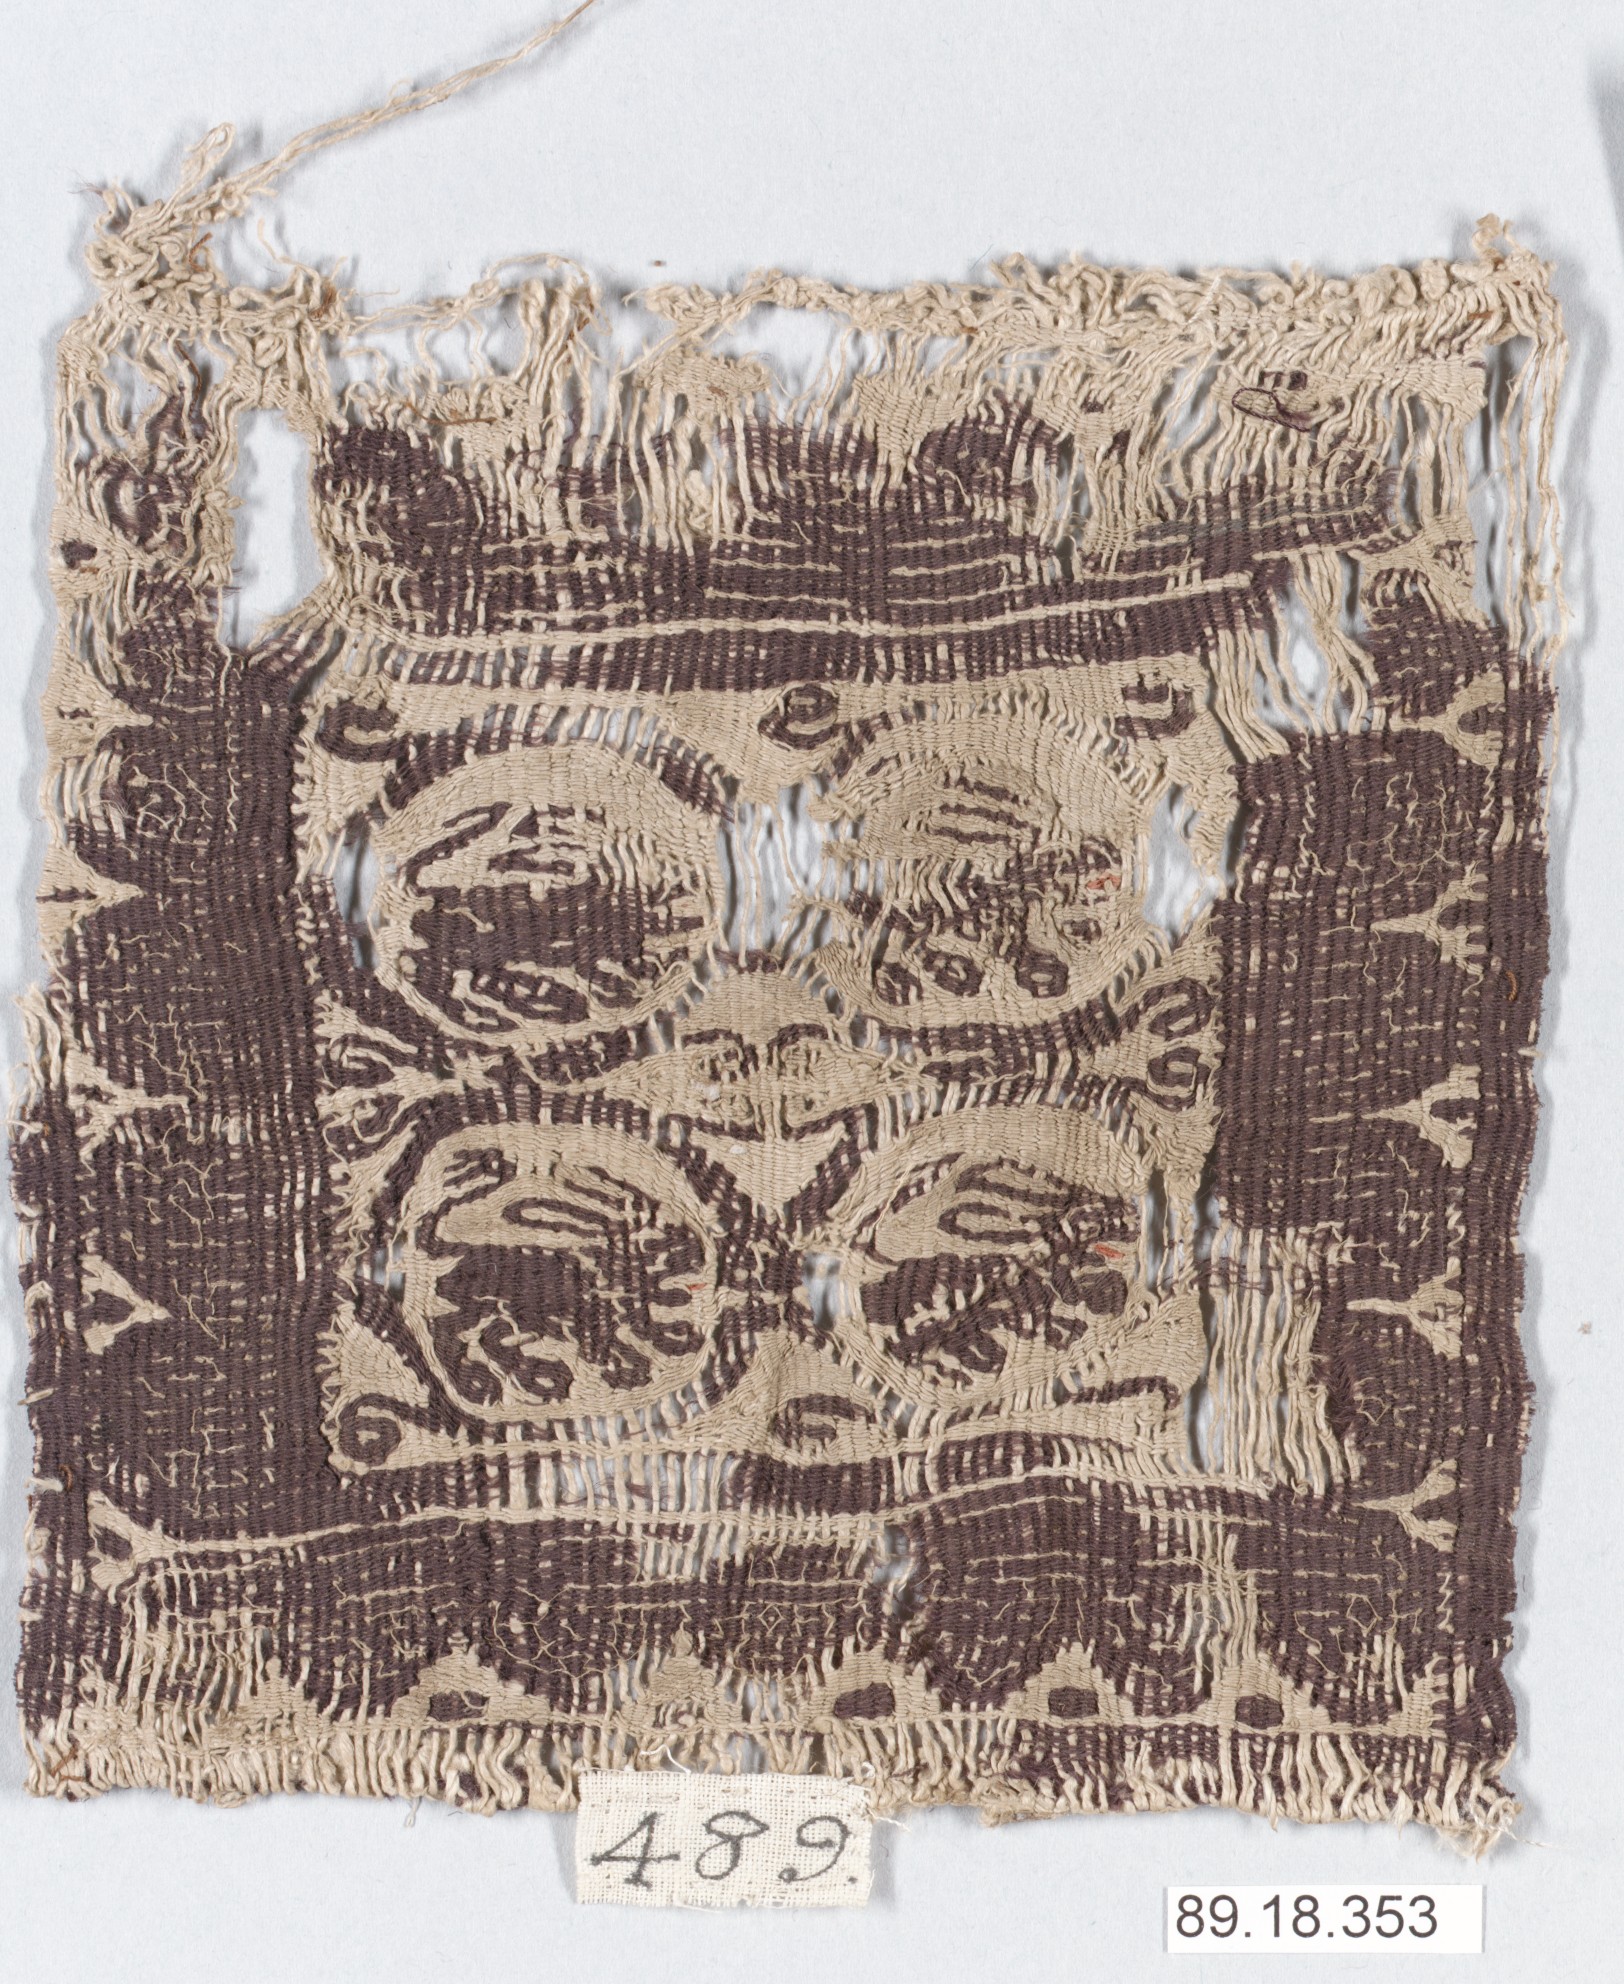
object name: textile fragment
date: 301-400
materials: linen, wool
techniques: weave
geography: egypt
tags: animals